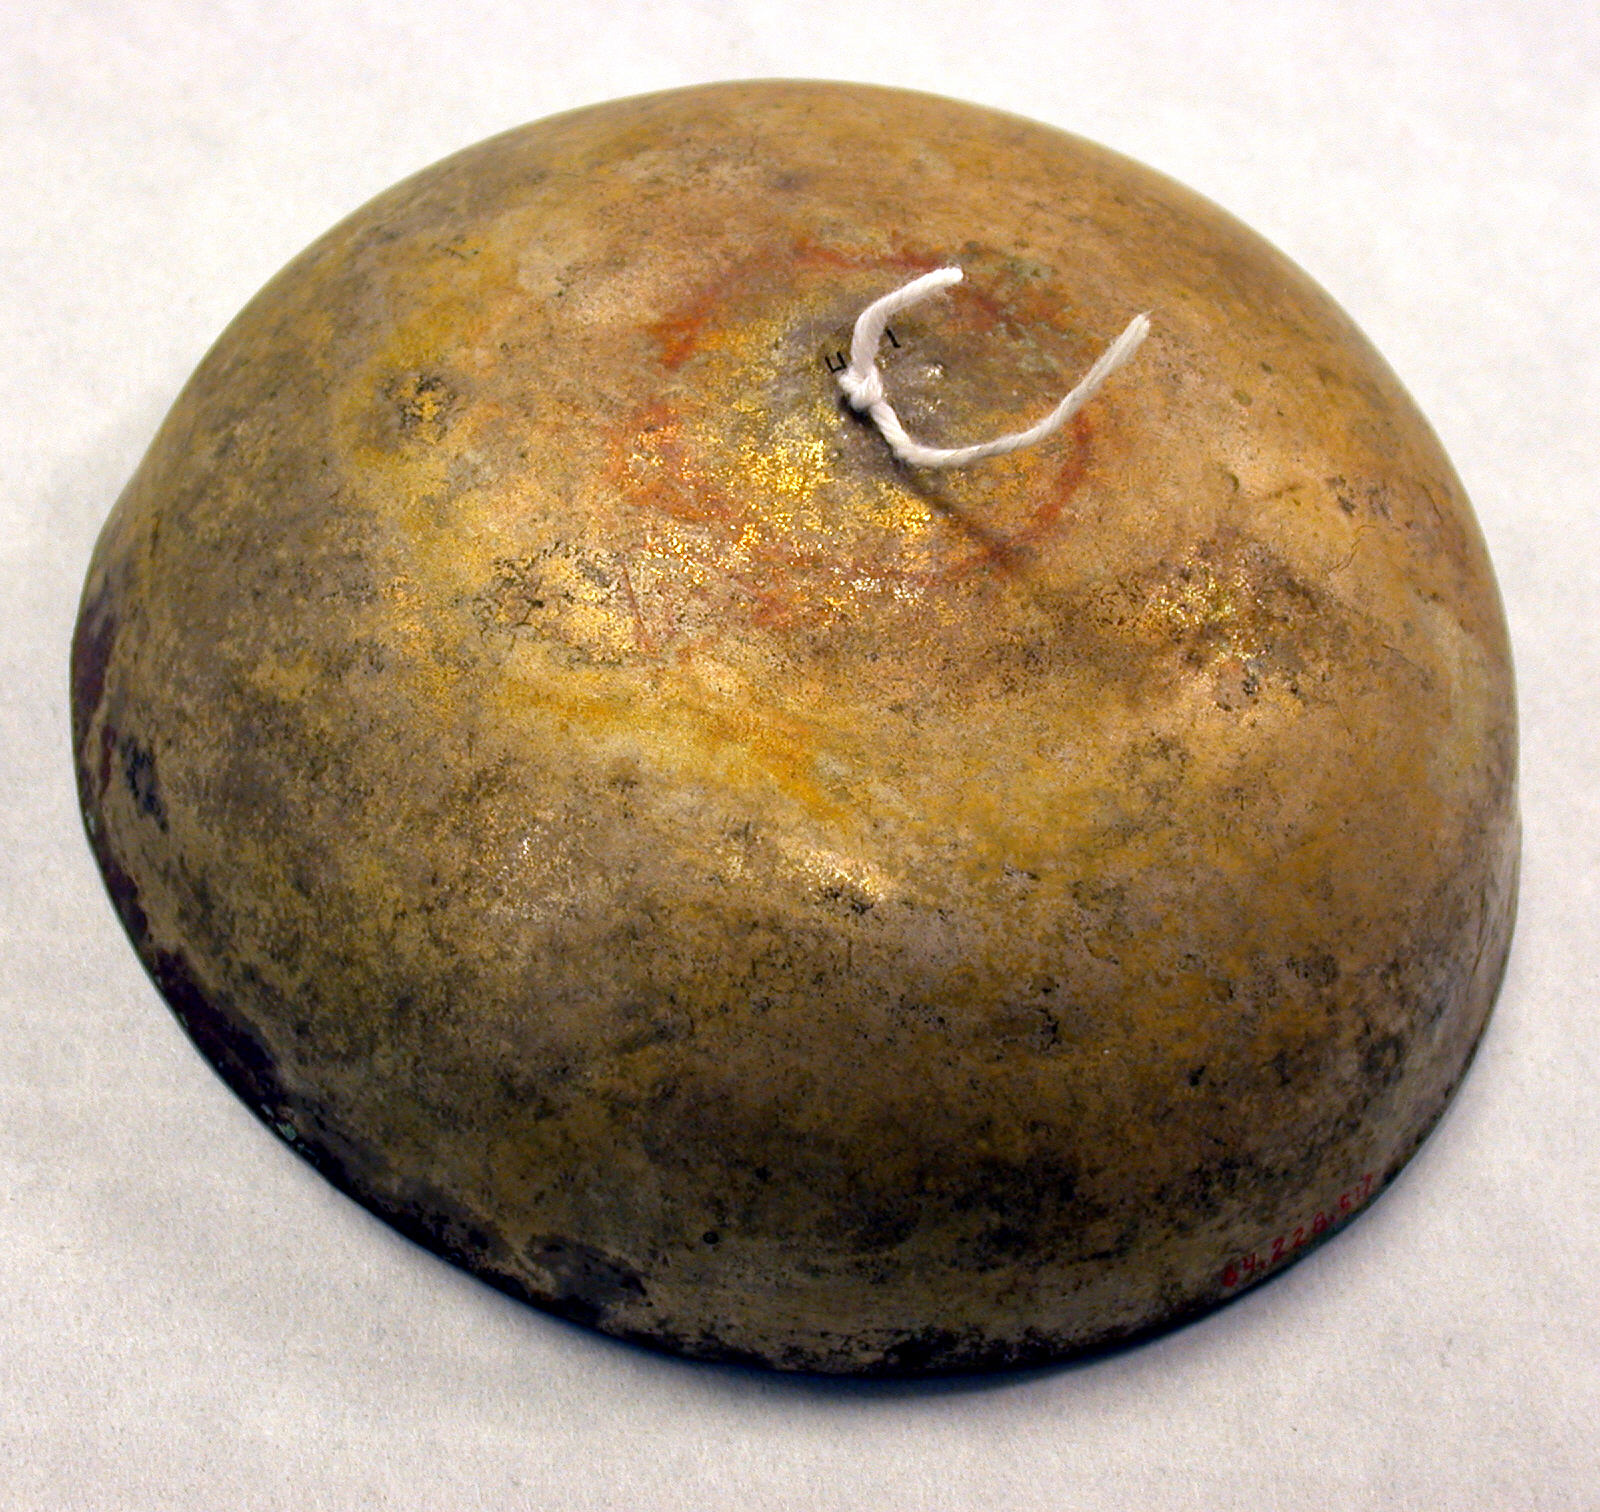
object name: dome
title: Hammered Copper Half Dome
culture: peruvian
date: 701-1566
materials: copper, gilt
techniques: hammering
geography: peru